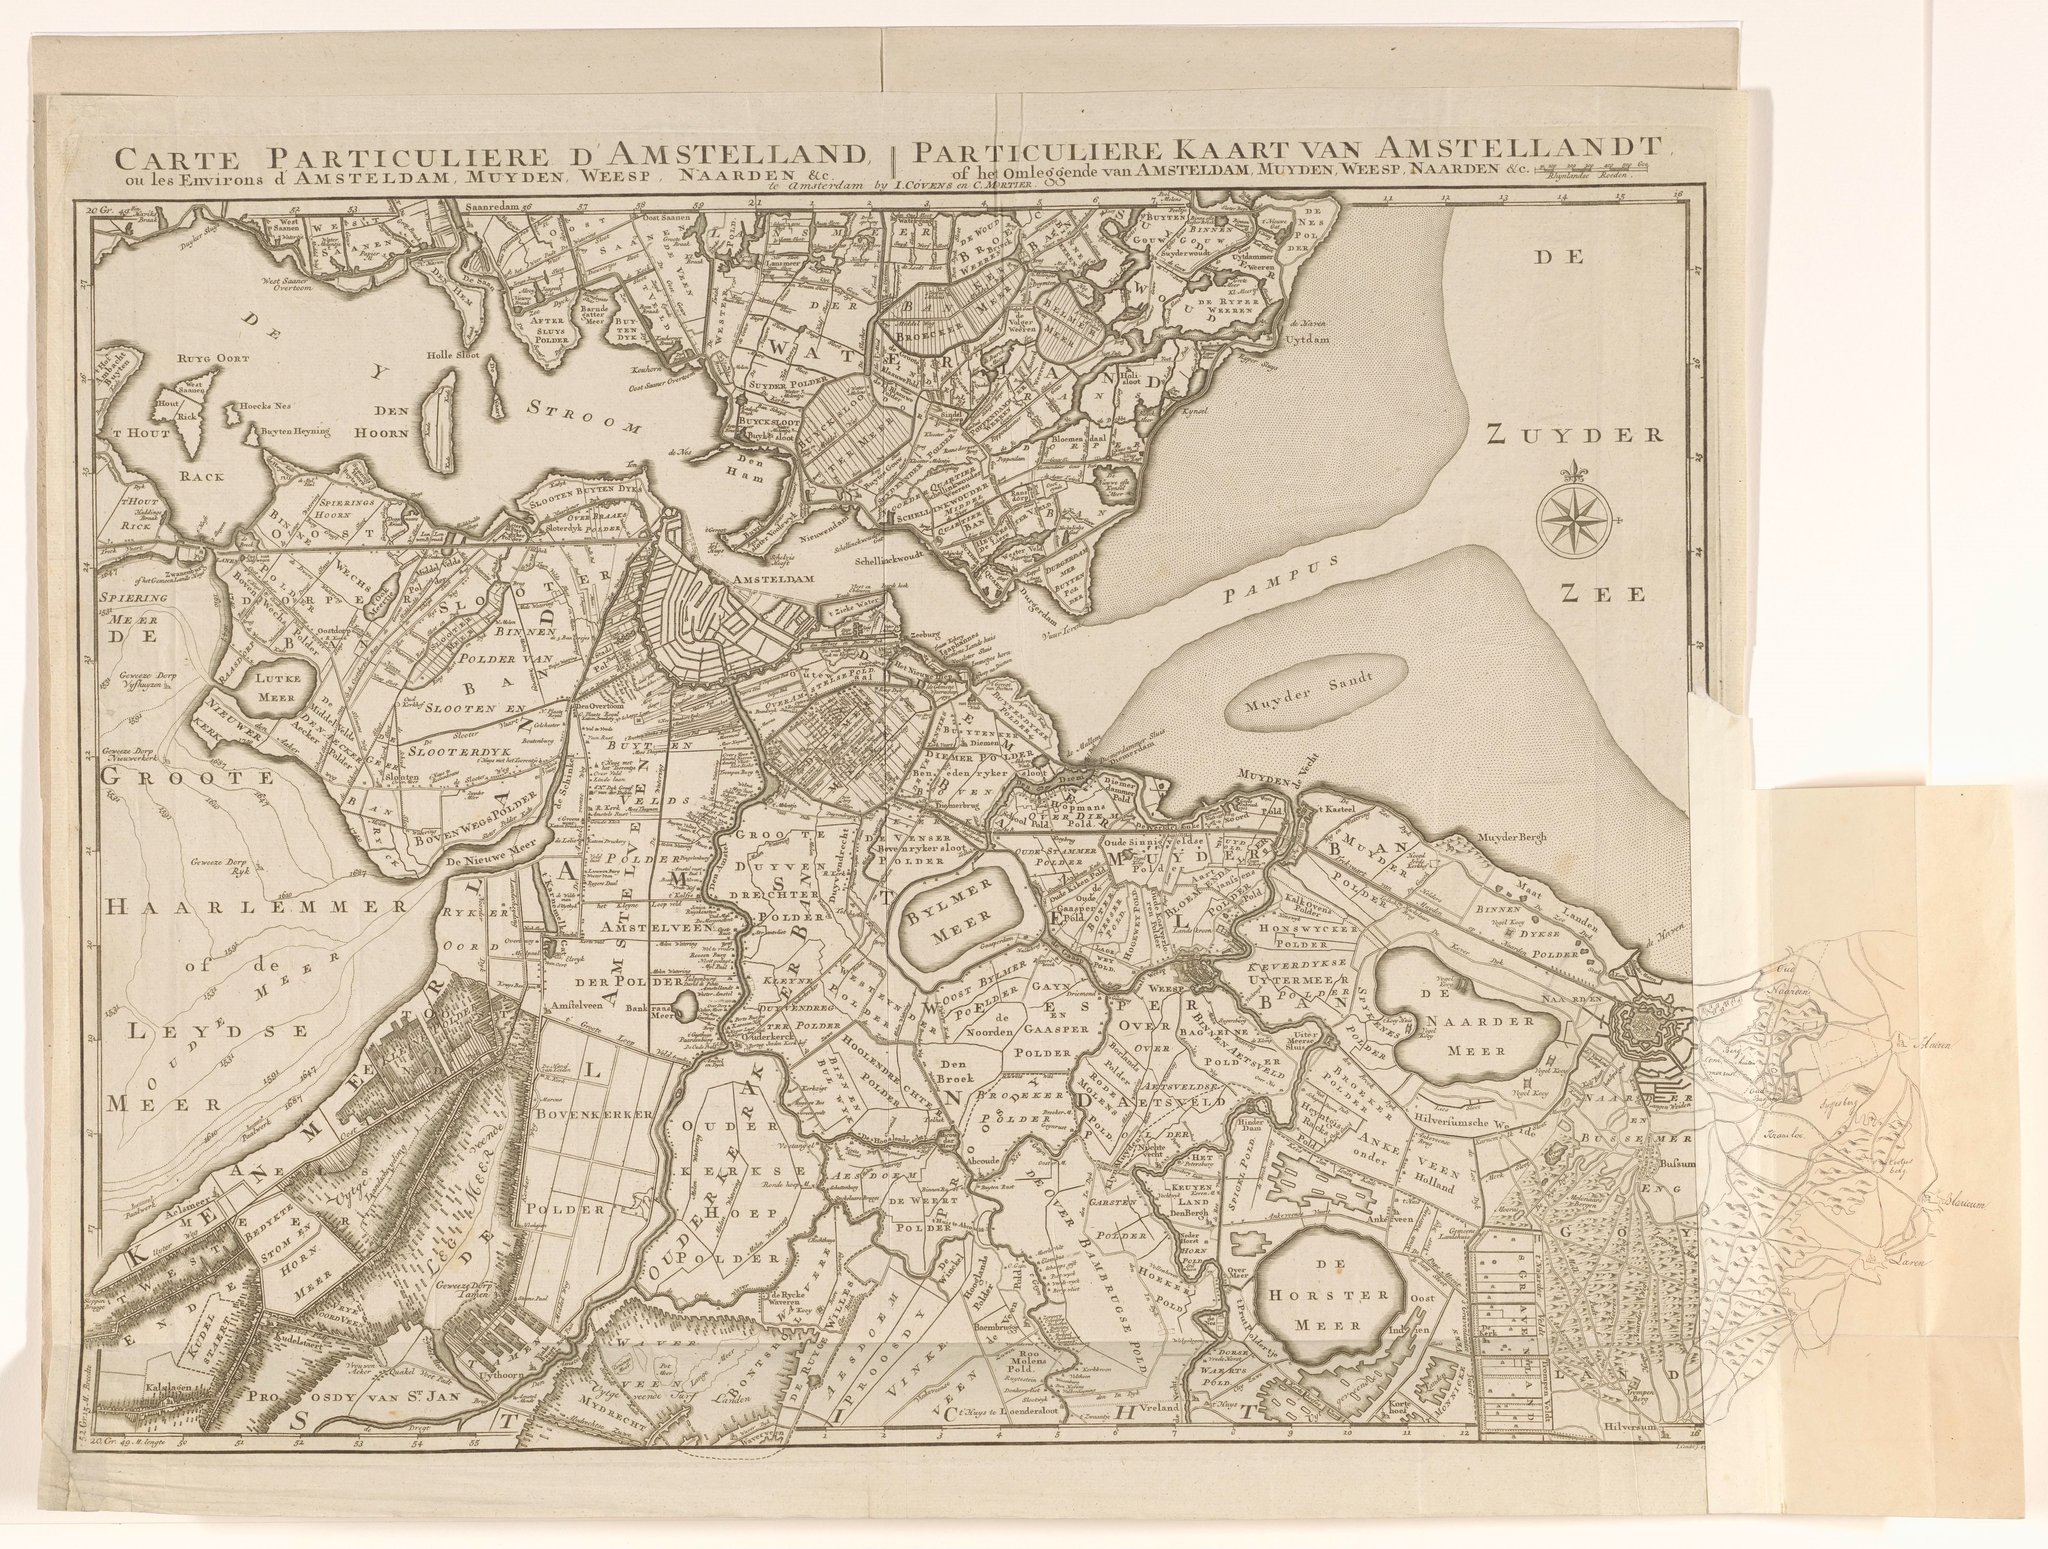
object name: map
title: Kaart van Amstelland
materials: ink, paper, pencil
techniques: brush, engraving, pen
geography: amsterdam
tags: maps of separate countries or regions, amsterdam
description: Prent (zonder de hier getekende toevoeging) ook gebruikt in: Atlas nouveau, contenant toutes les parties du monde, ou sont exactement remarquées les empires, monarchies, royaumes, etats, republiques &c. (…). Amsterdam: Covens & Mortier, s.a. [na 1757]. Zie ook RP-P-AO-8-72-2 en RP-P-AO-8-72-3.